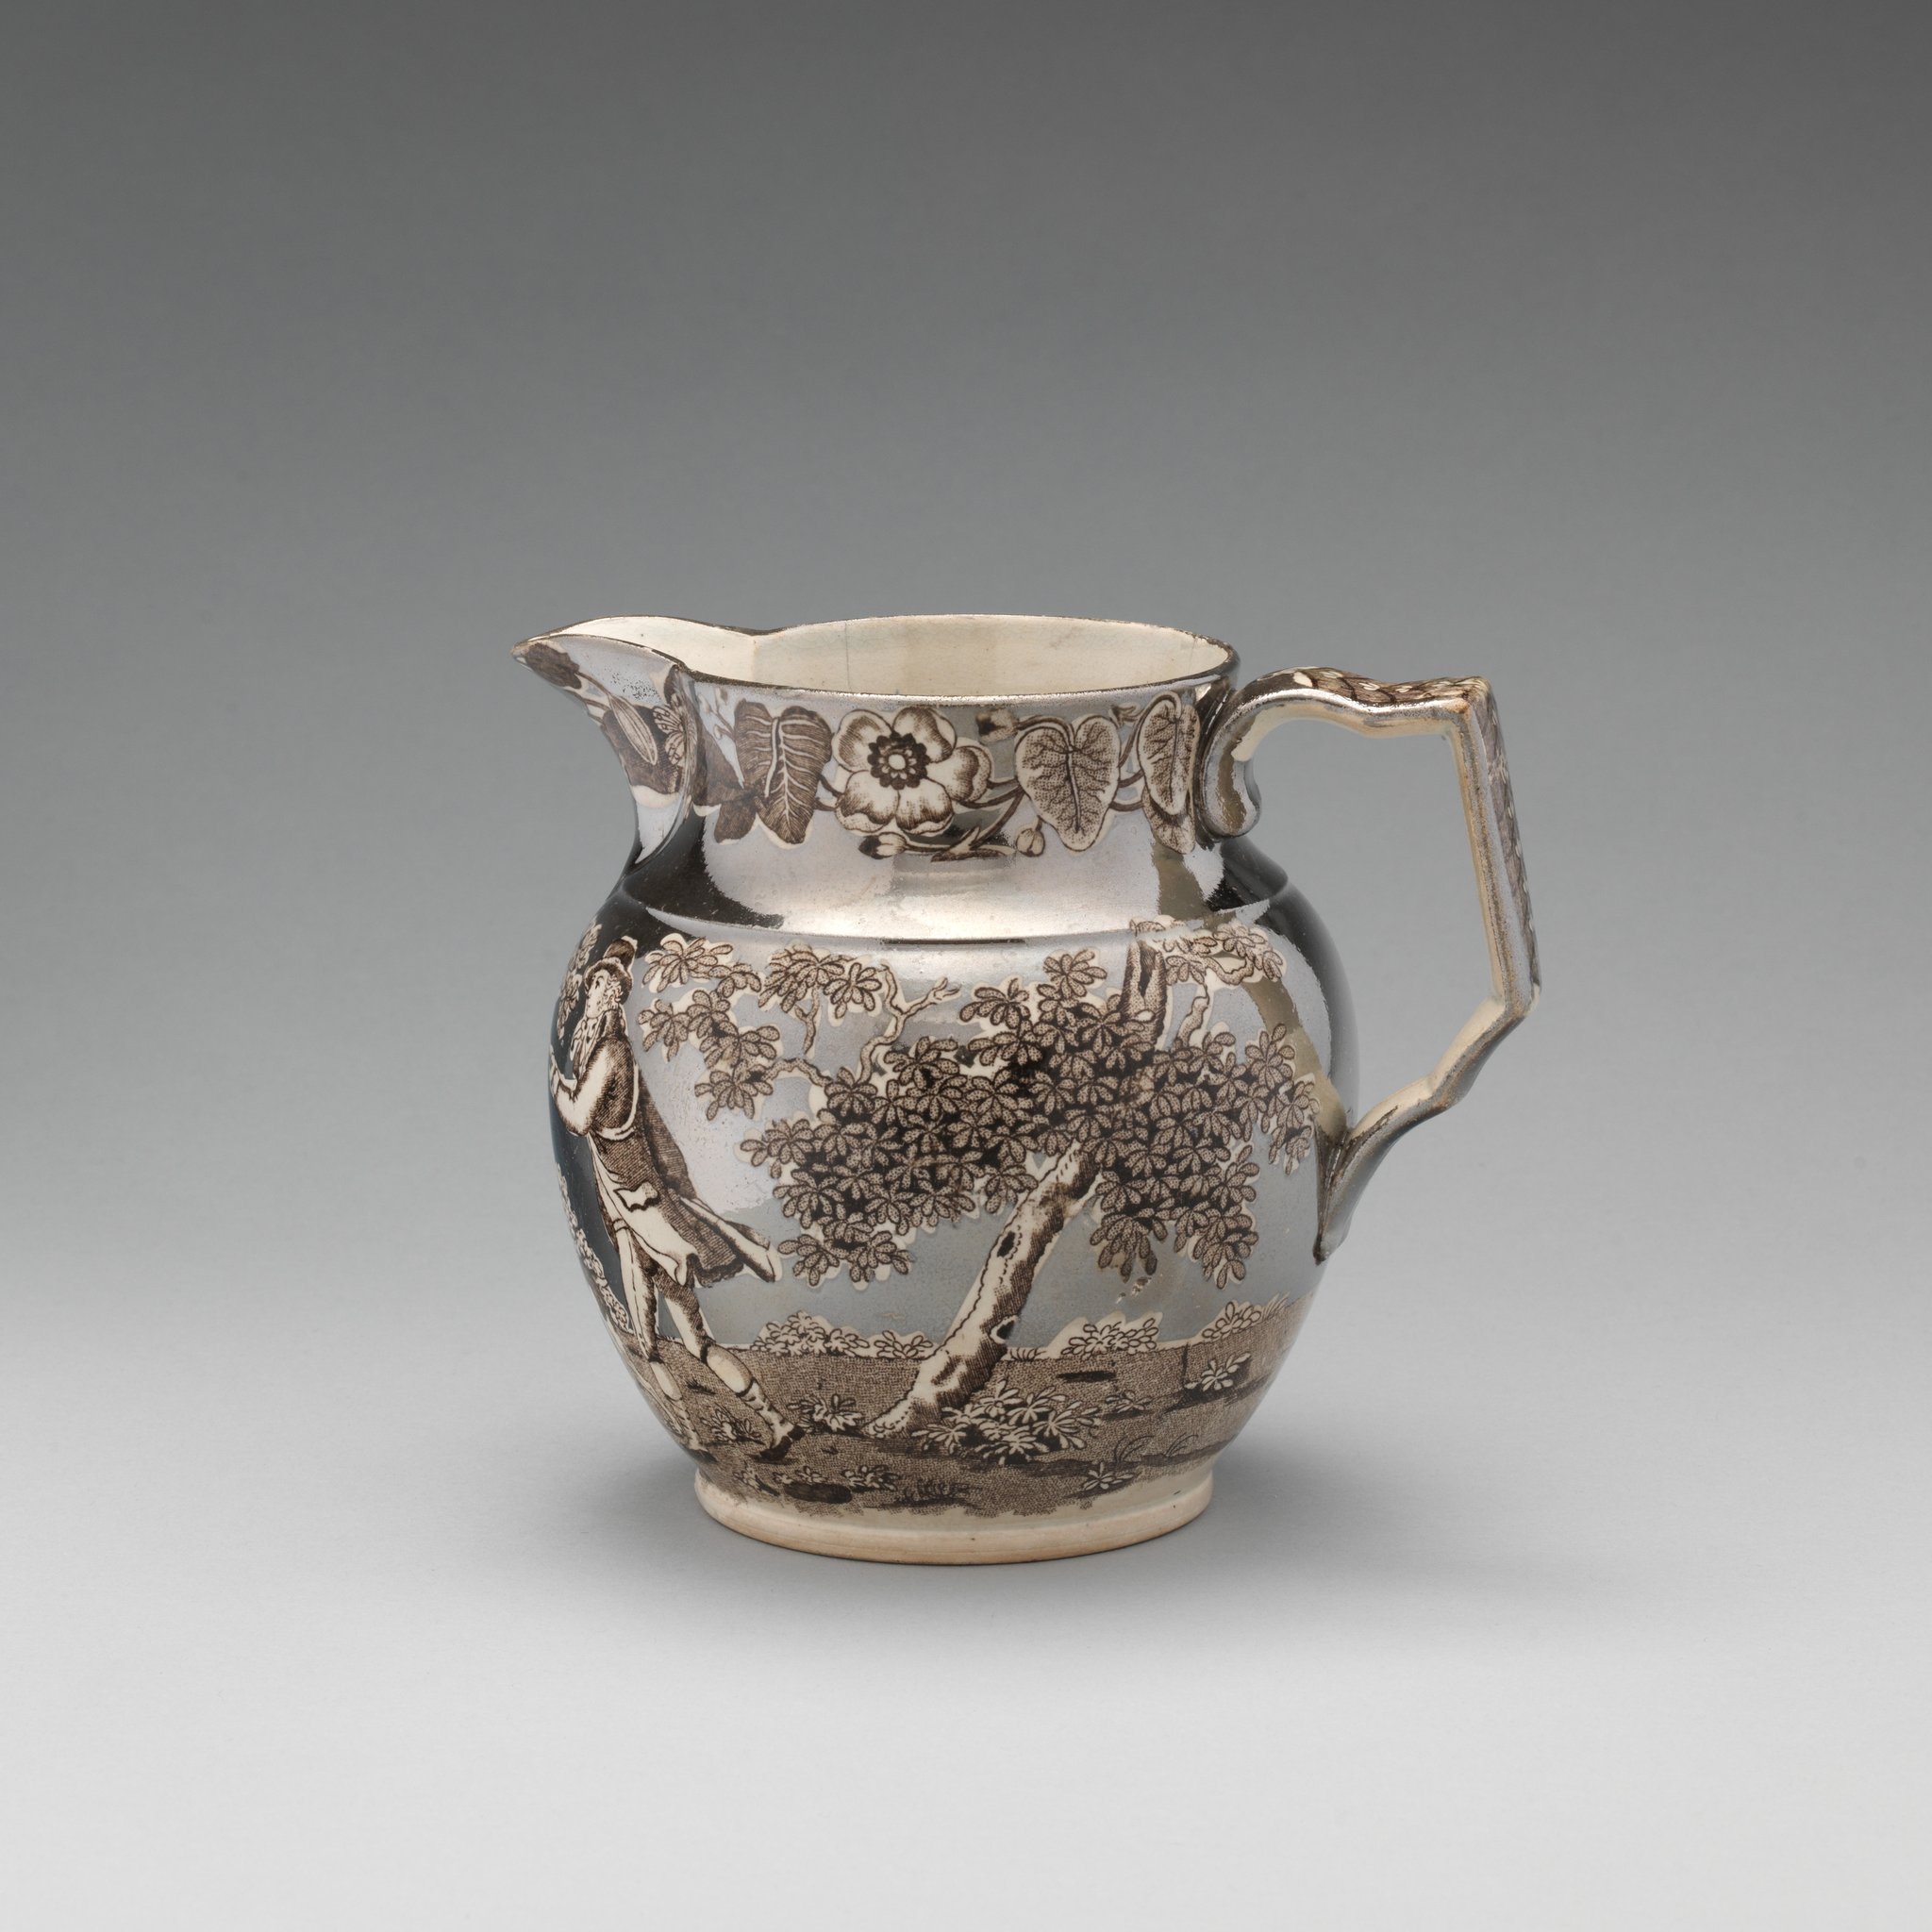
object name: jug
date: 1801-1900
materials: earthenware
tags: men,dogs,flowers,trees